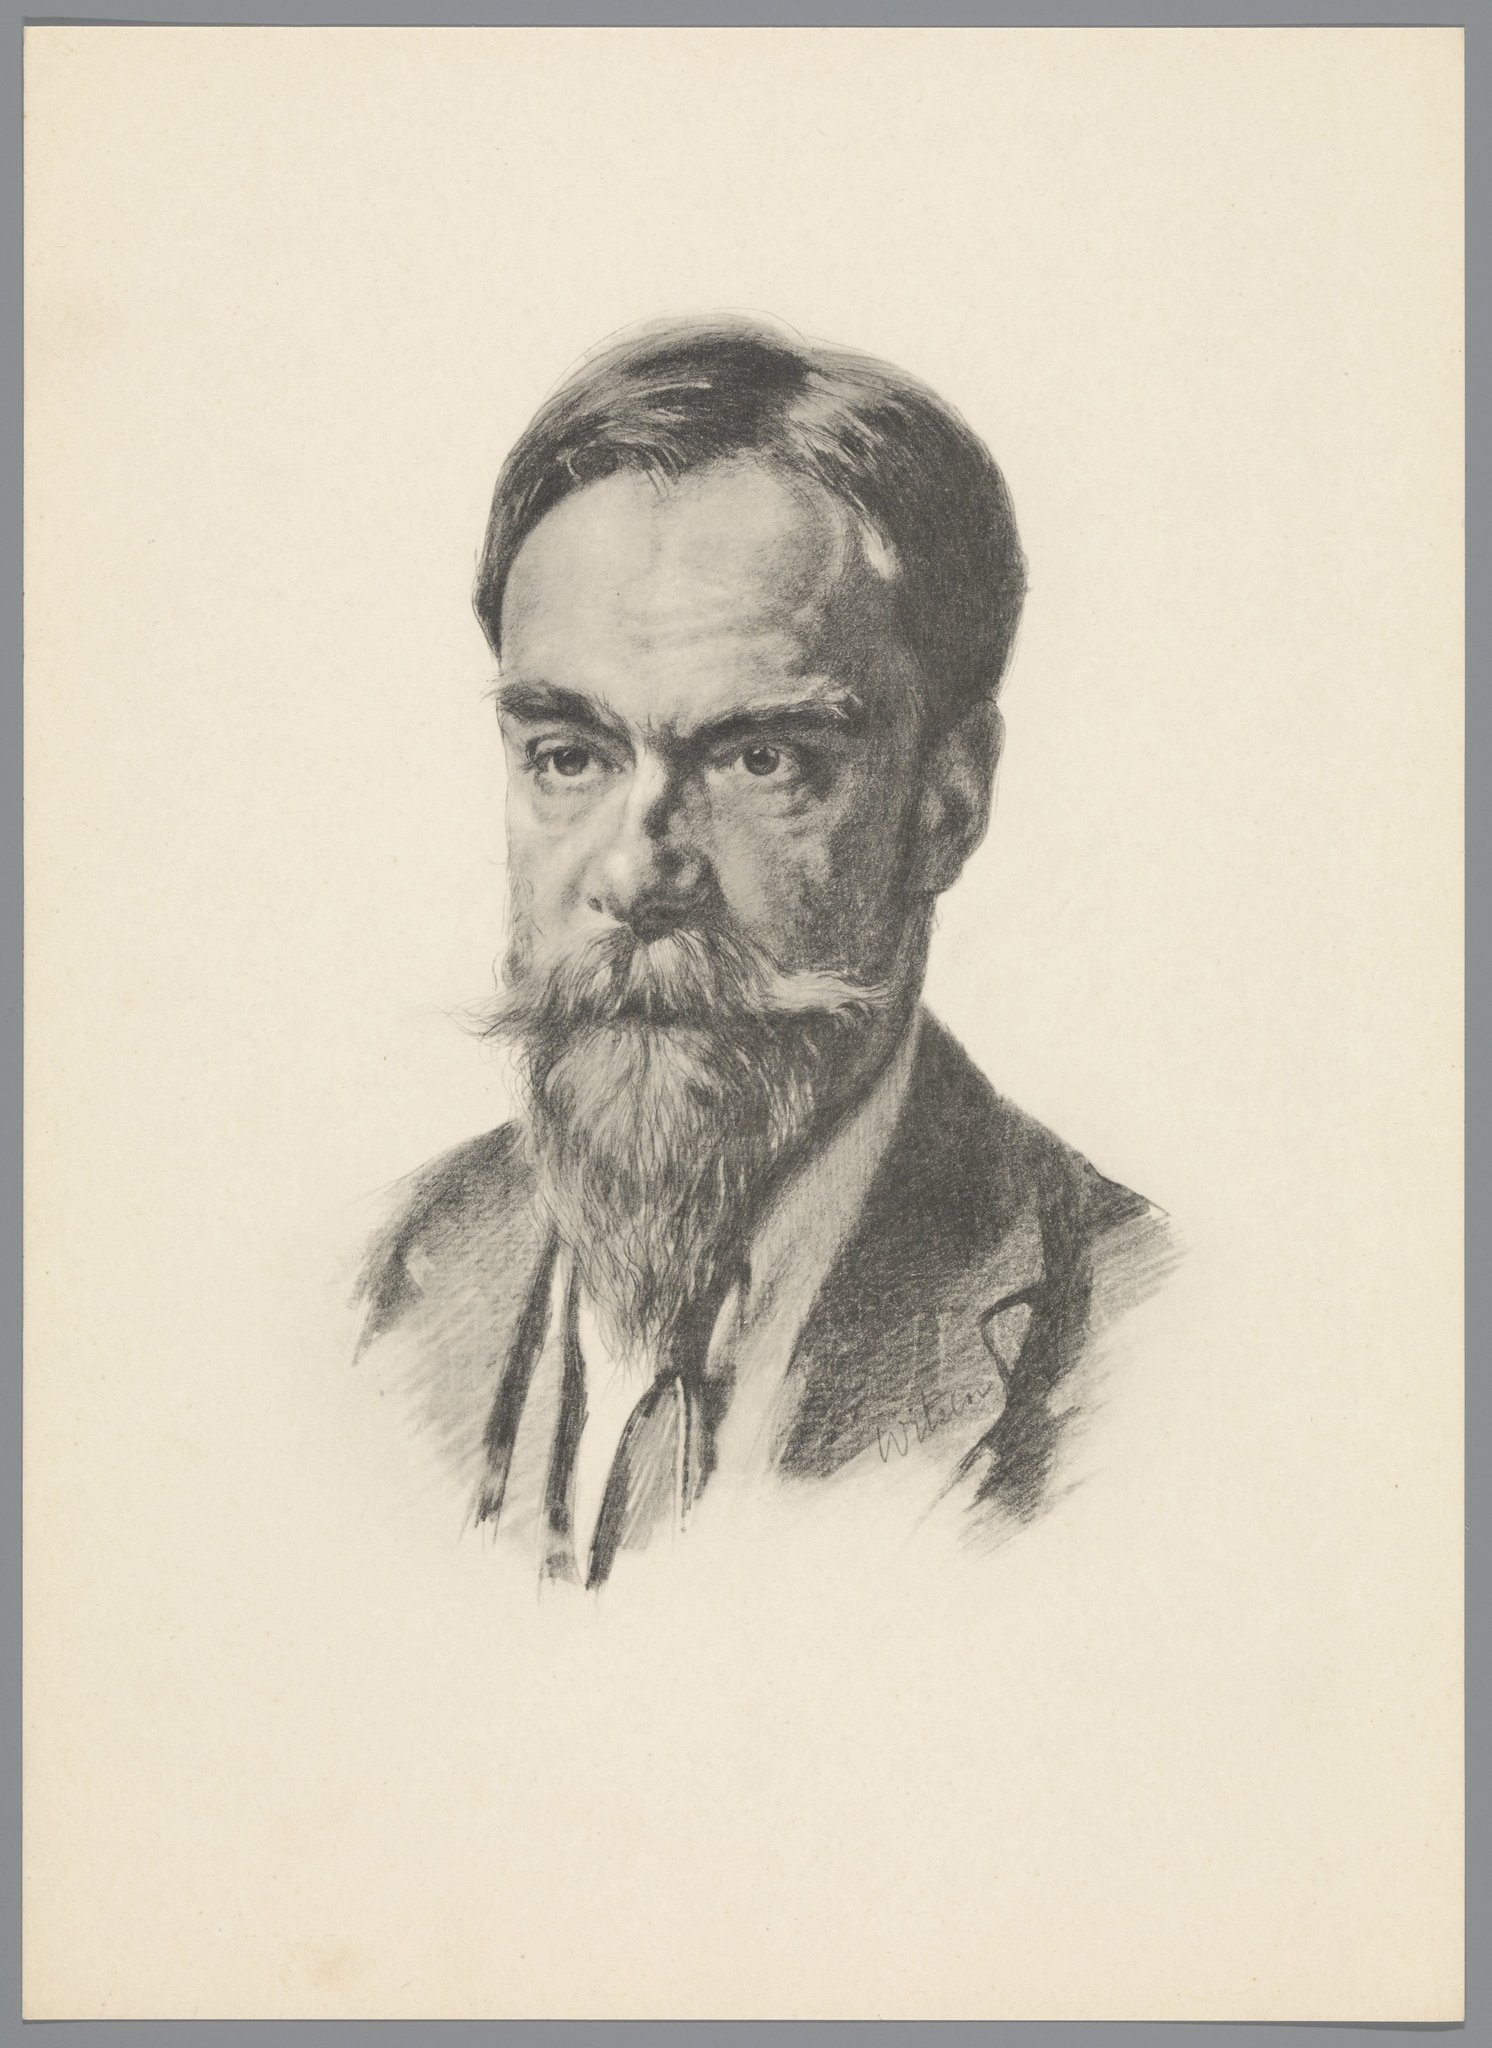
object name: print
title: Reproductie naar krijttekening met portret van Frans Coenen Jr.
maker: Anonymous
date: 1860-1915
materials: paper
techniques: photograph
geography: netherlands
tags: frans coenen (1866-1936)